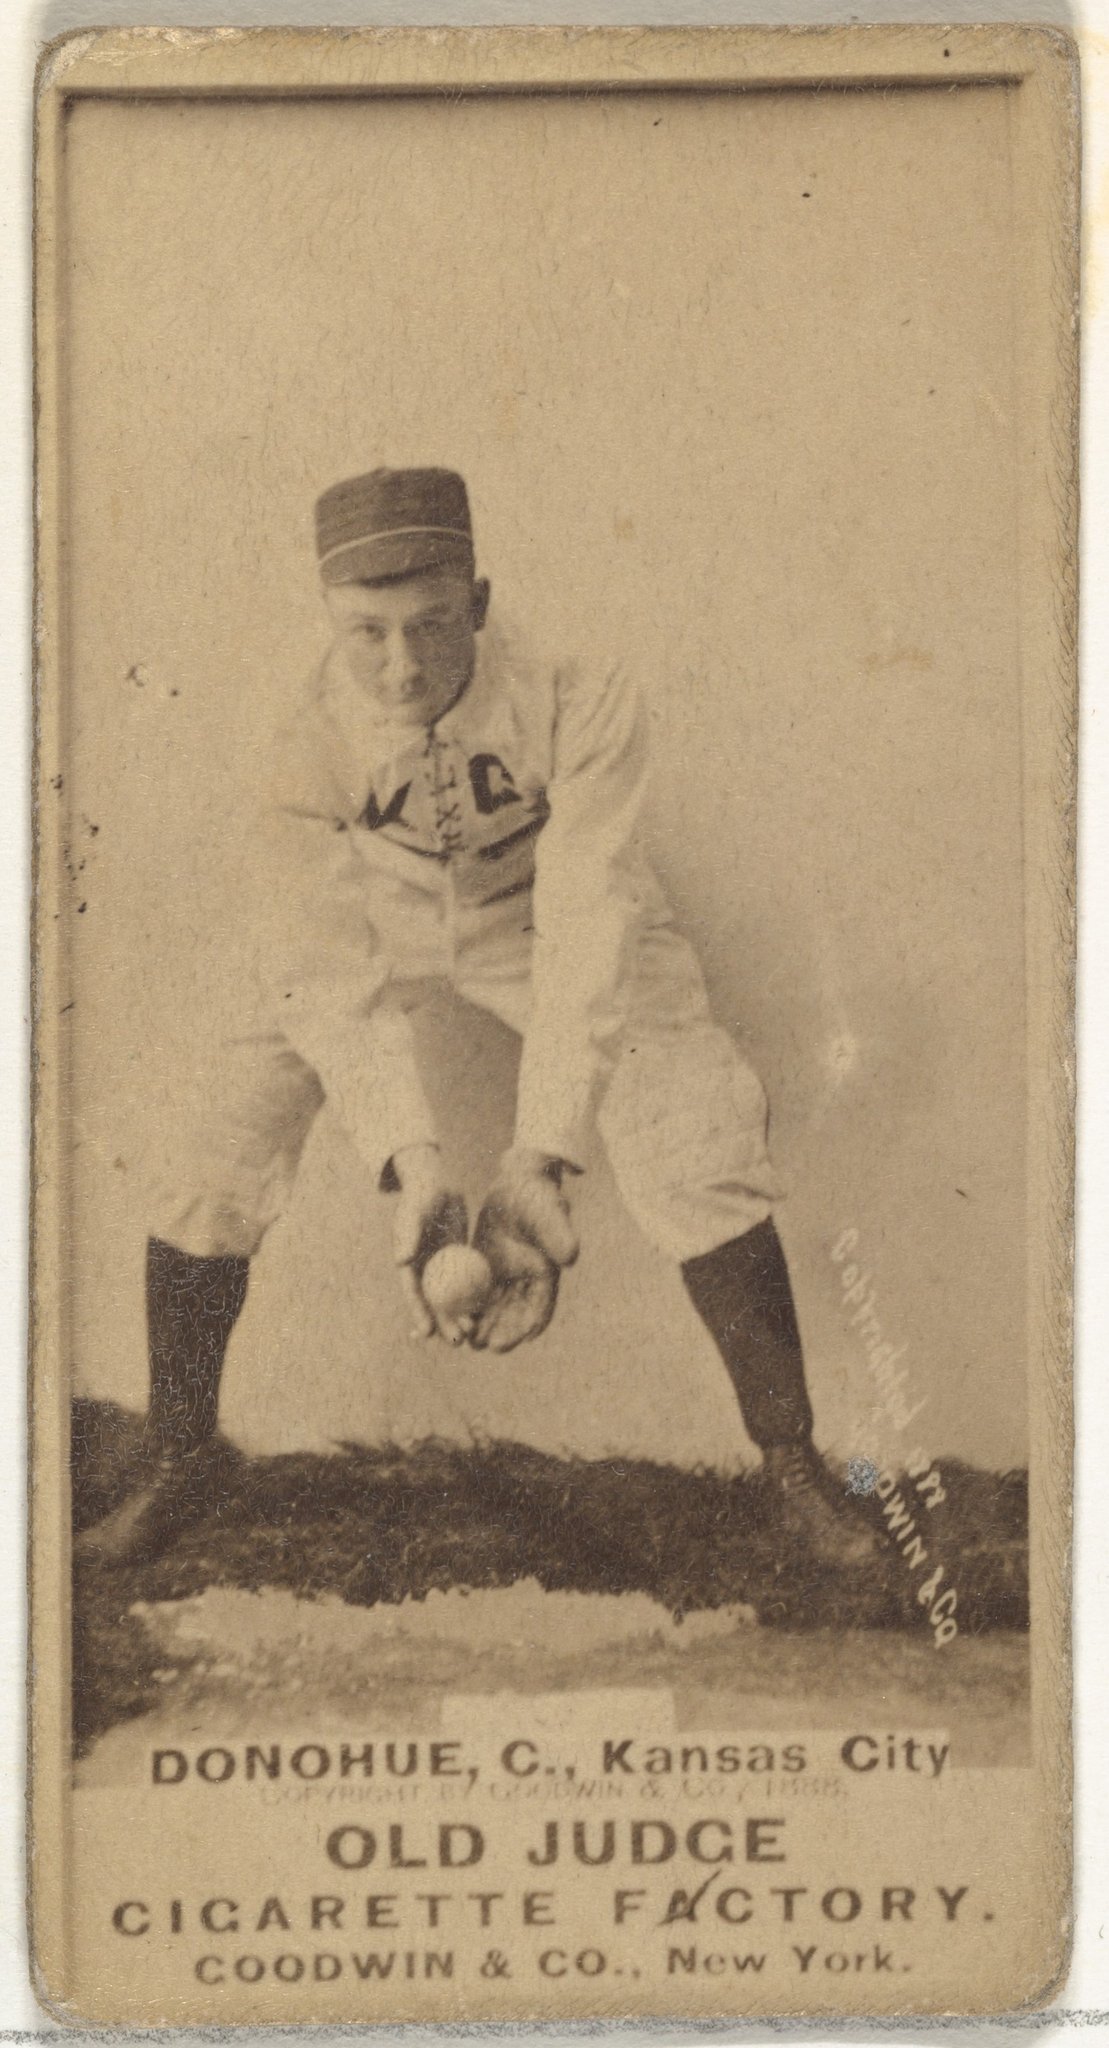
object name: baseball card, photograph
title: James Augustus "Jim" Donahue, Catcher, Kansas City Cowboys, from the Old Judge series (N172) for Old Judge Cigarettes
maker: goodwin & company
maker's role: publisher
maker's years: 1850-1950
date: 1888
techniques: albumen silver print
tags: men,portraits,baseball,athletes